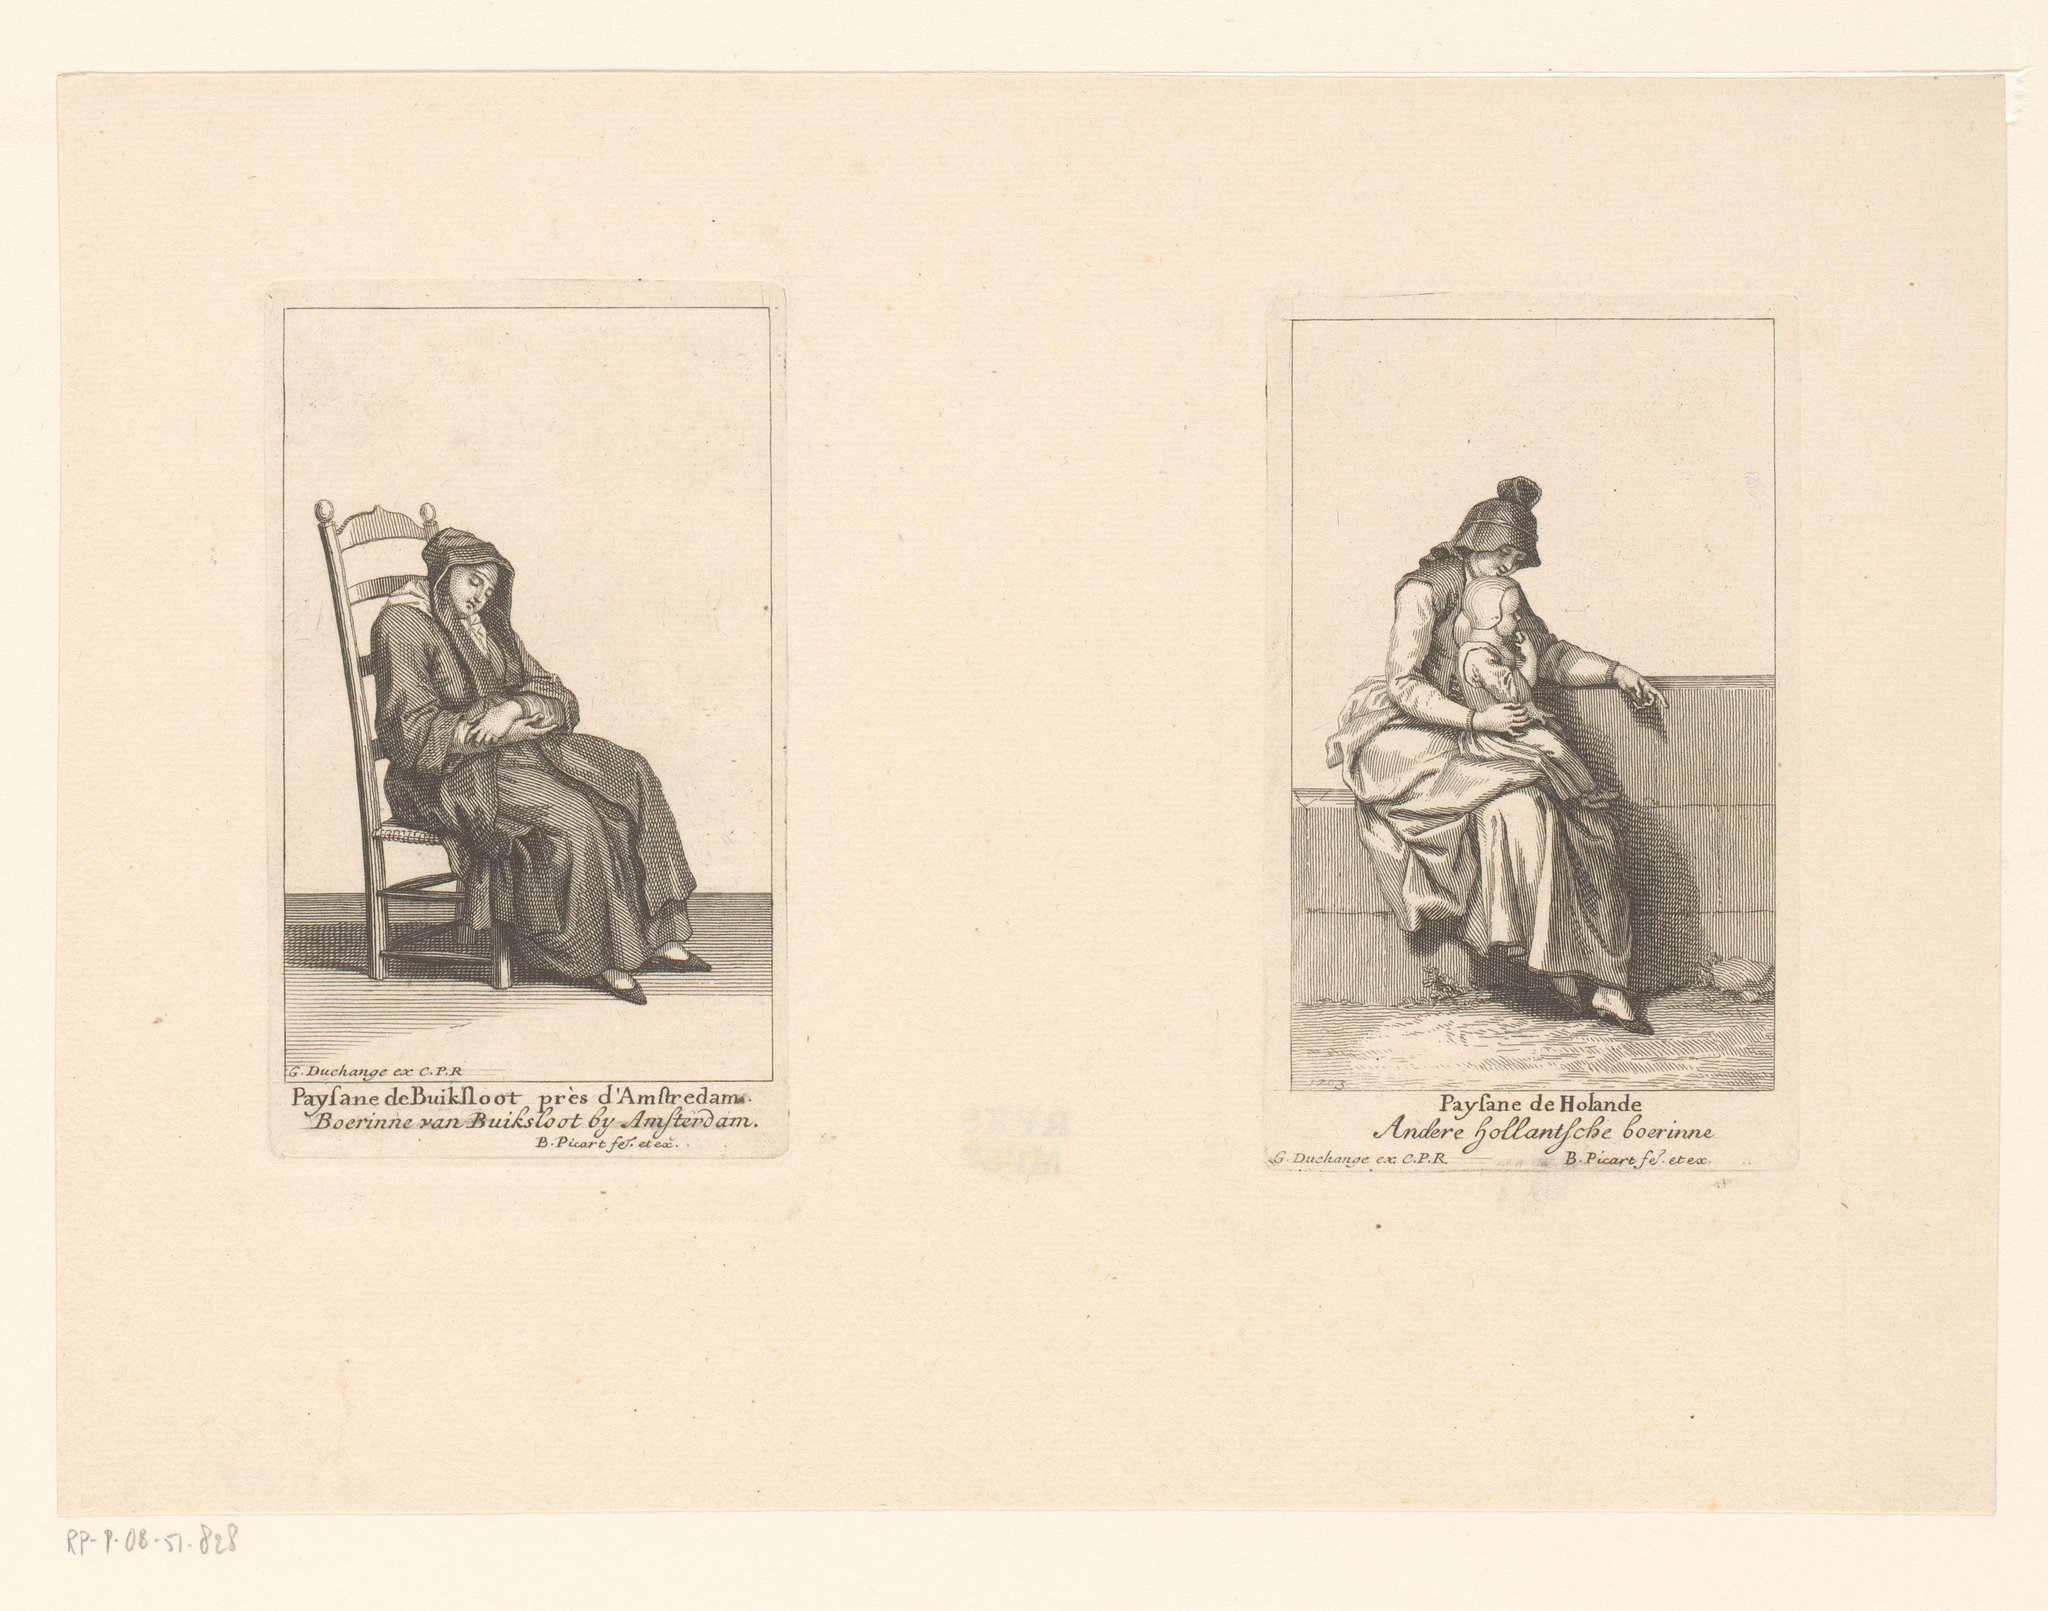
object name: print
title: Paysane de Holande / Andere hollantsche boerinne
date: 1703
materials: paper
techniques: etching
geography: paris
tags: sleeping in chair, farmers - aa - female farmer, farmer's wife, mother and baby or young child, folk costume, regional costume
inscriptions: collector's mark: Lugt 2165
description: De rechterprent is gedateerd 1703, maar de serie als geheel werd in 1728 uitgegeven.